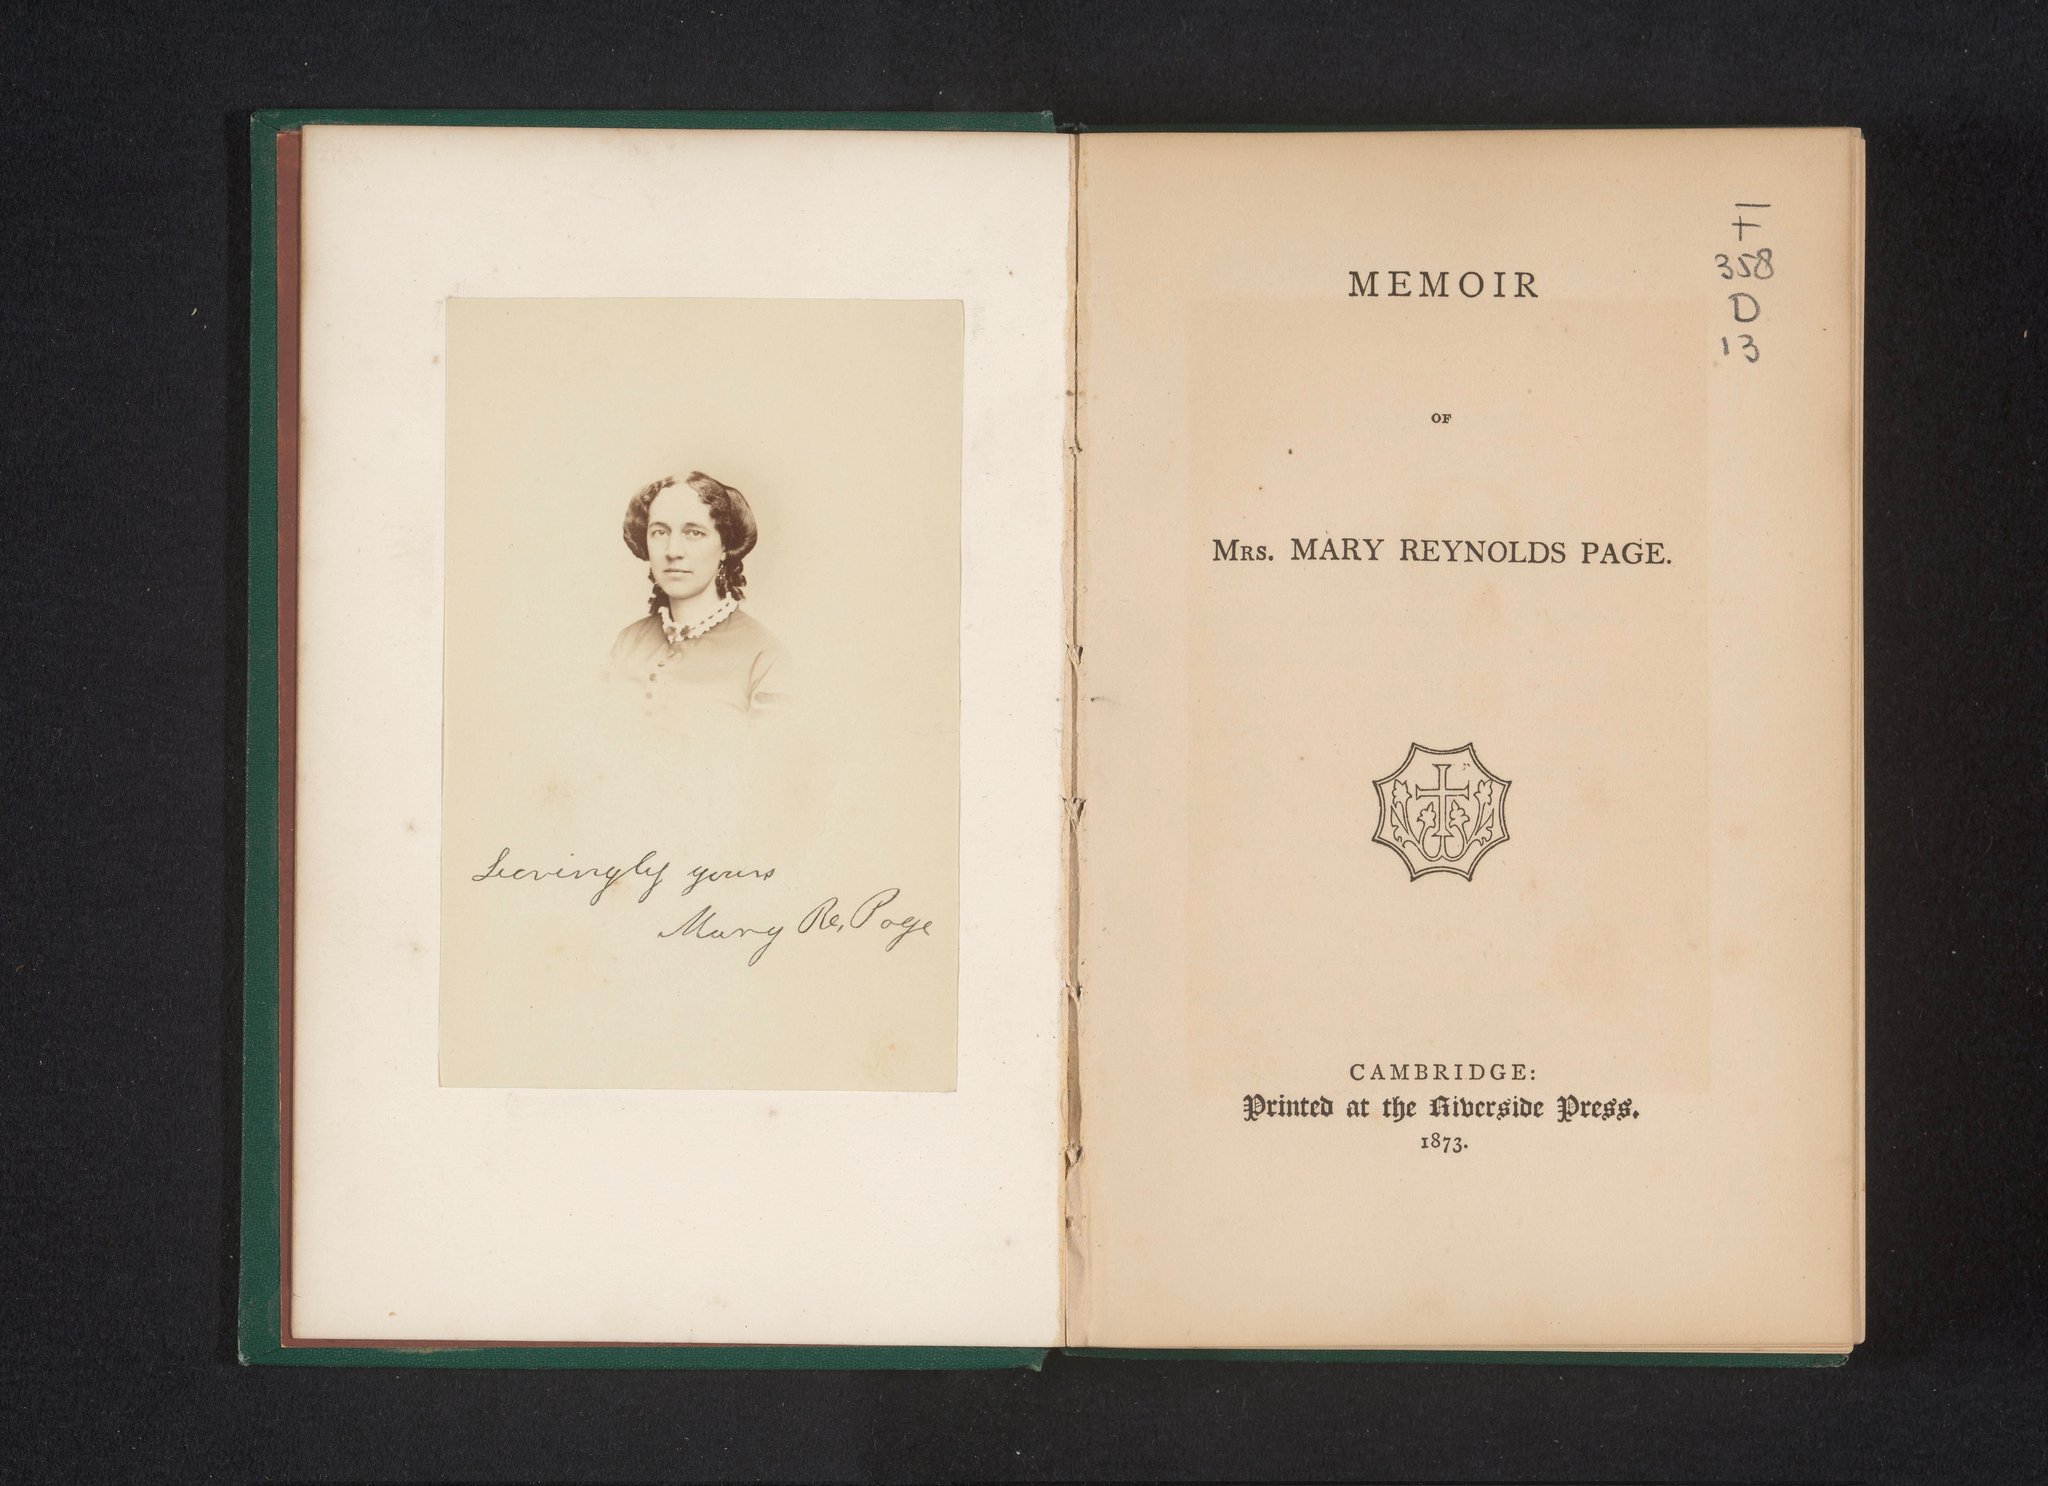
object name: book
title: Memoir of Mrs. Mary Reynolds Page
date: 1873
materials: cardboard, linen, paper, photographic support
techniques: albumen print, printing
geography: cambridge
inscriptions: inscription: ‘Bristol Library Association’